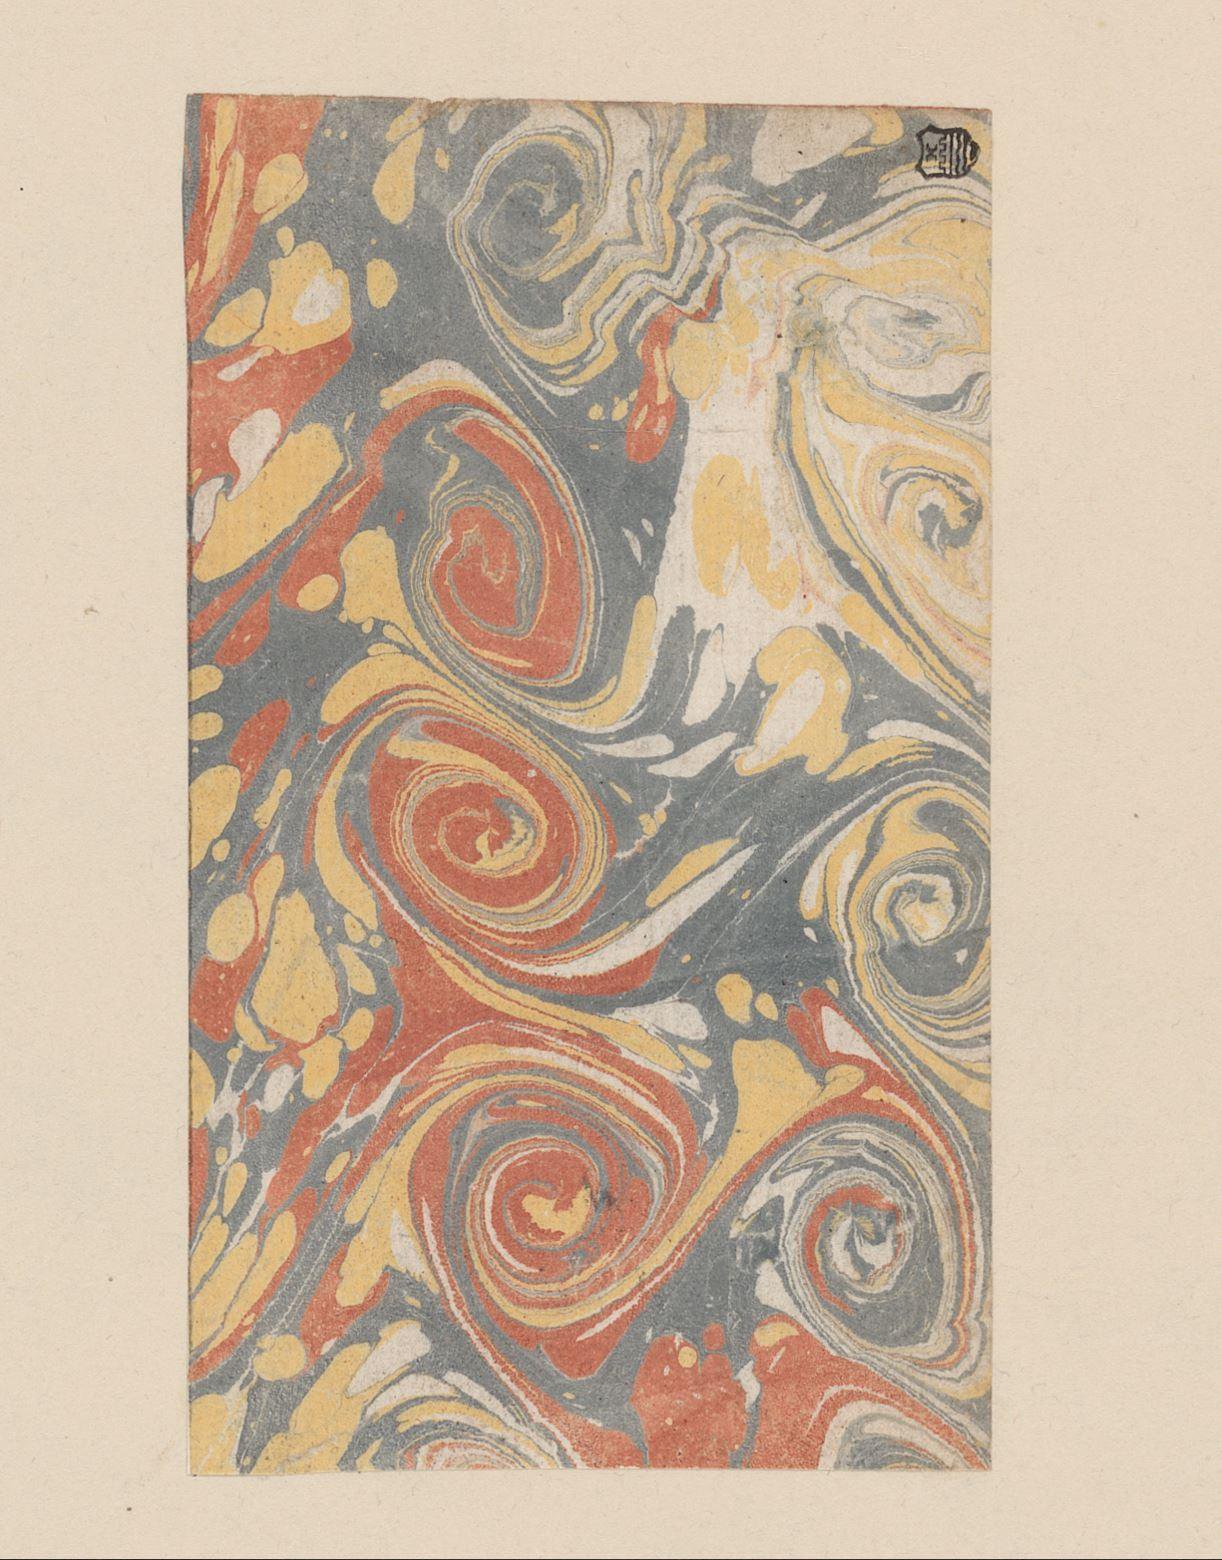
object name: marbled paper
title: Spiraalmarmer in blauw, rood en geel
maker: Anonymous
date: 1700-1850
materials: paint, paper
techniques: marbled paper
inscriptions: collector's mark: Lugt 2760